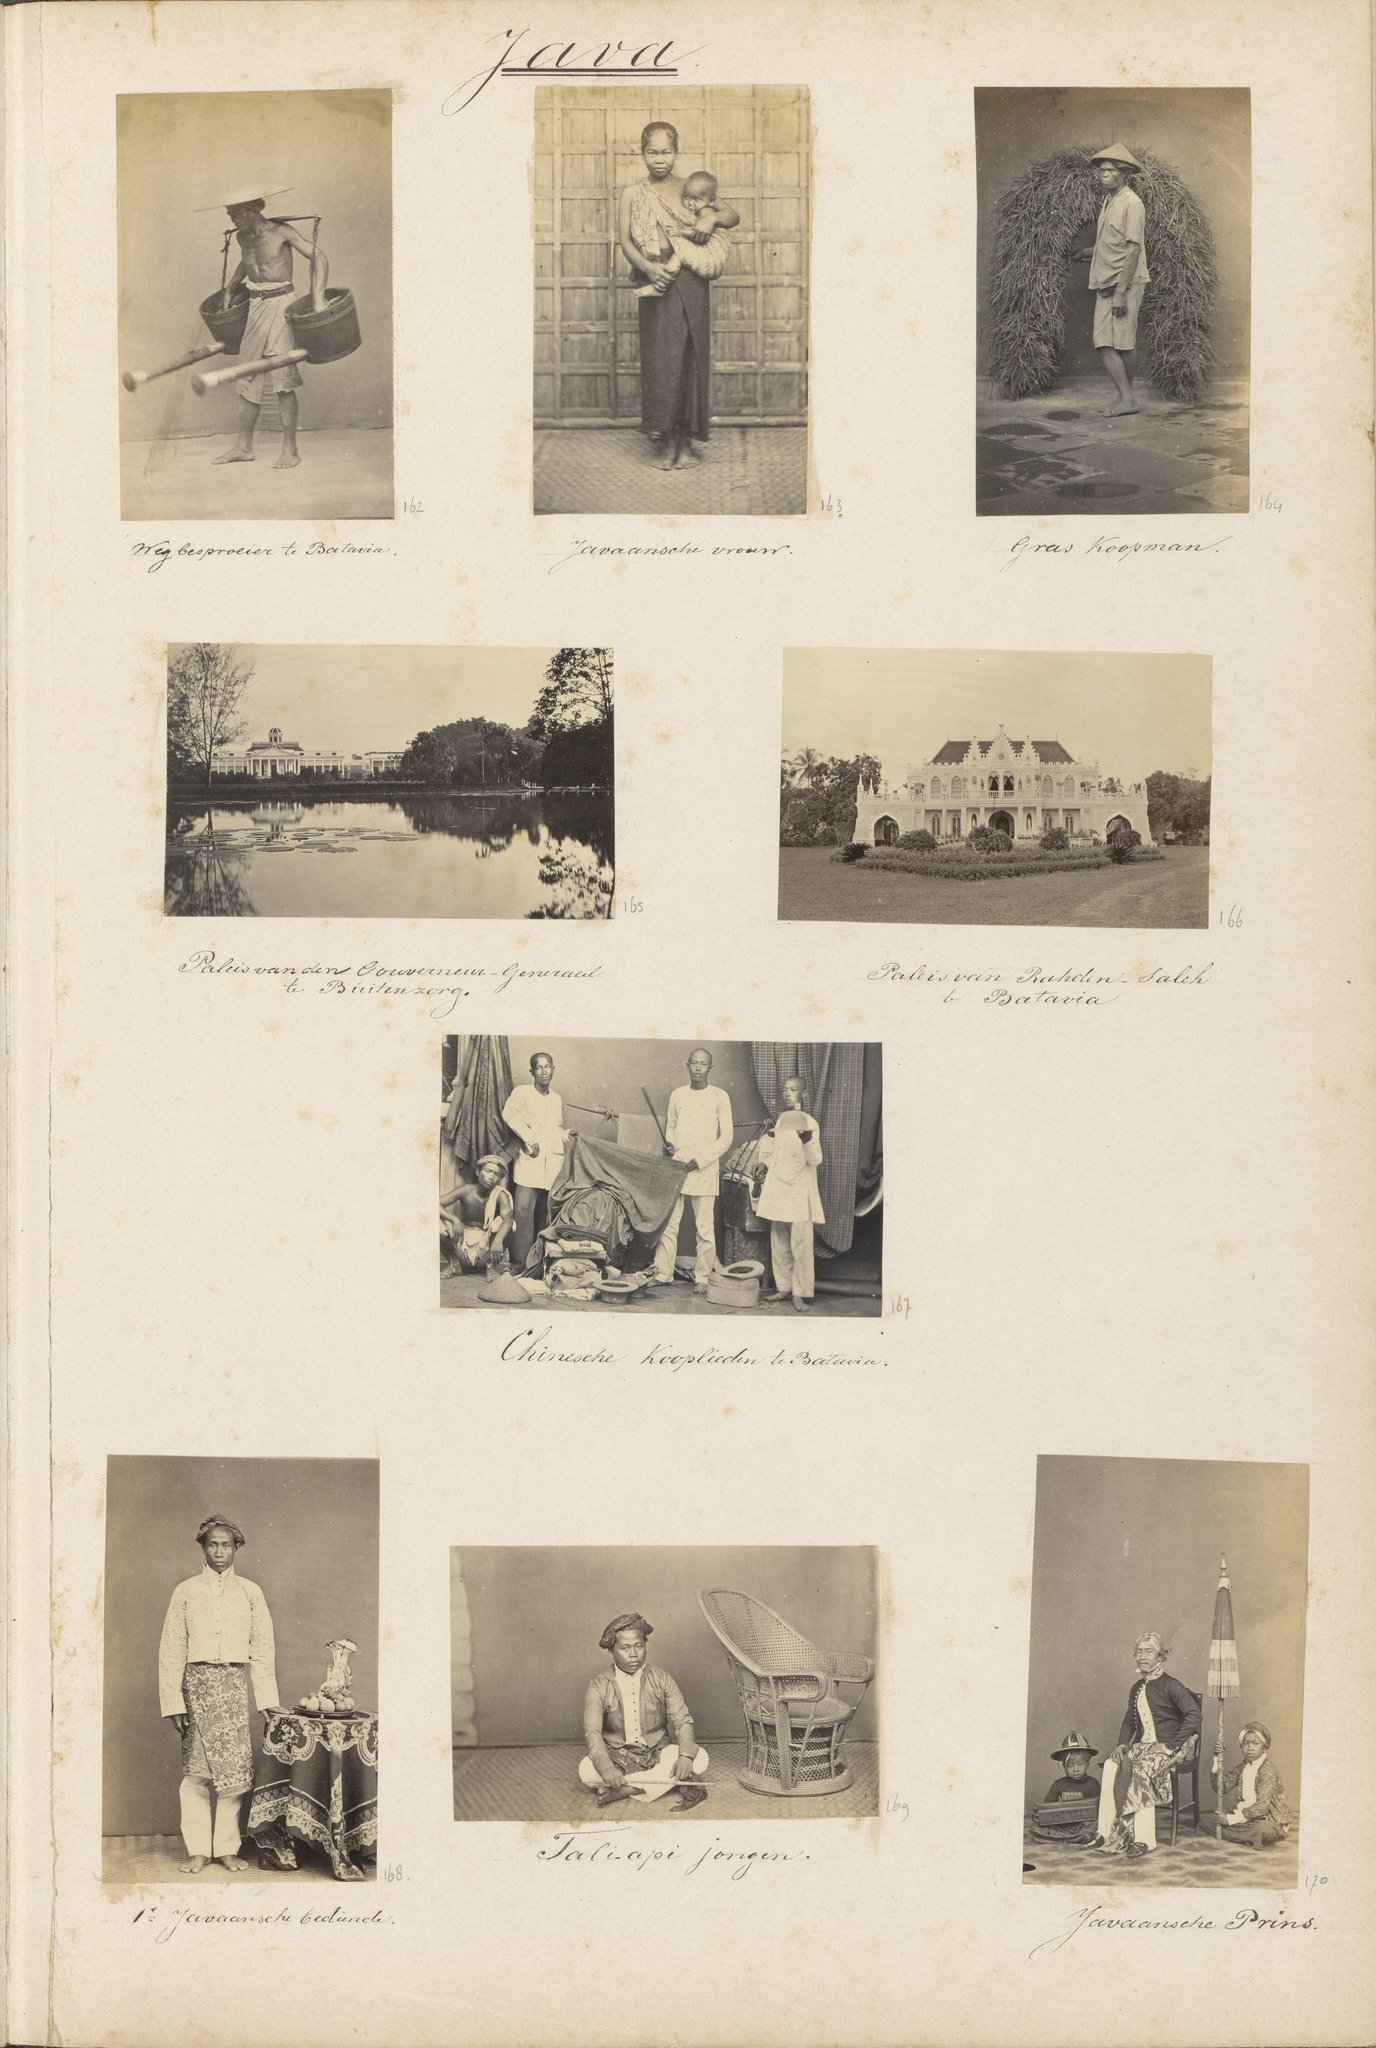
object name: album leaf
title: Portret van een Javaanse vrouw met een kind in een draagdoek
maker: Anonymous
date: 1870-1880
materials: paper, photographic support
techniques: albumen print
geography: java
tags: mother and baby or young child, java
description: Onderdeel van Fotoalbum van Robert Daniel Crommelin (1841-1907).